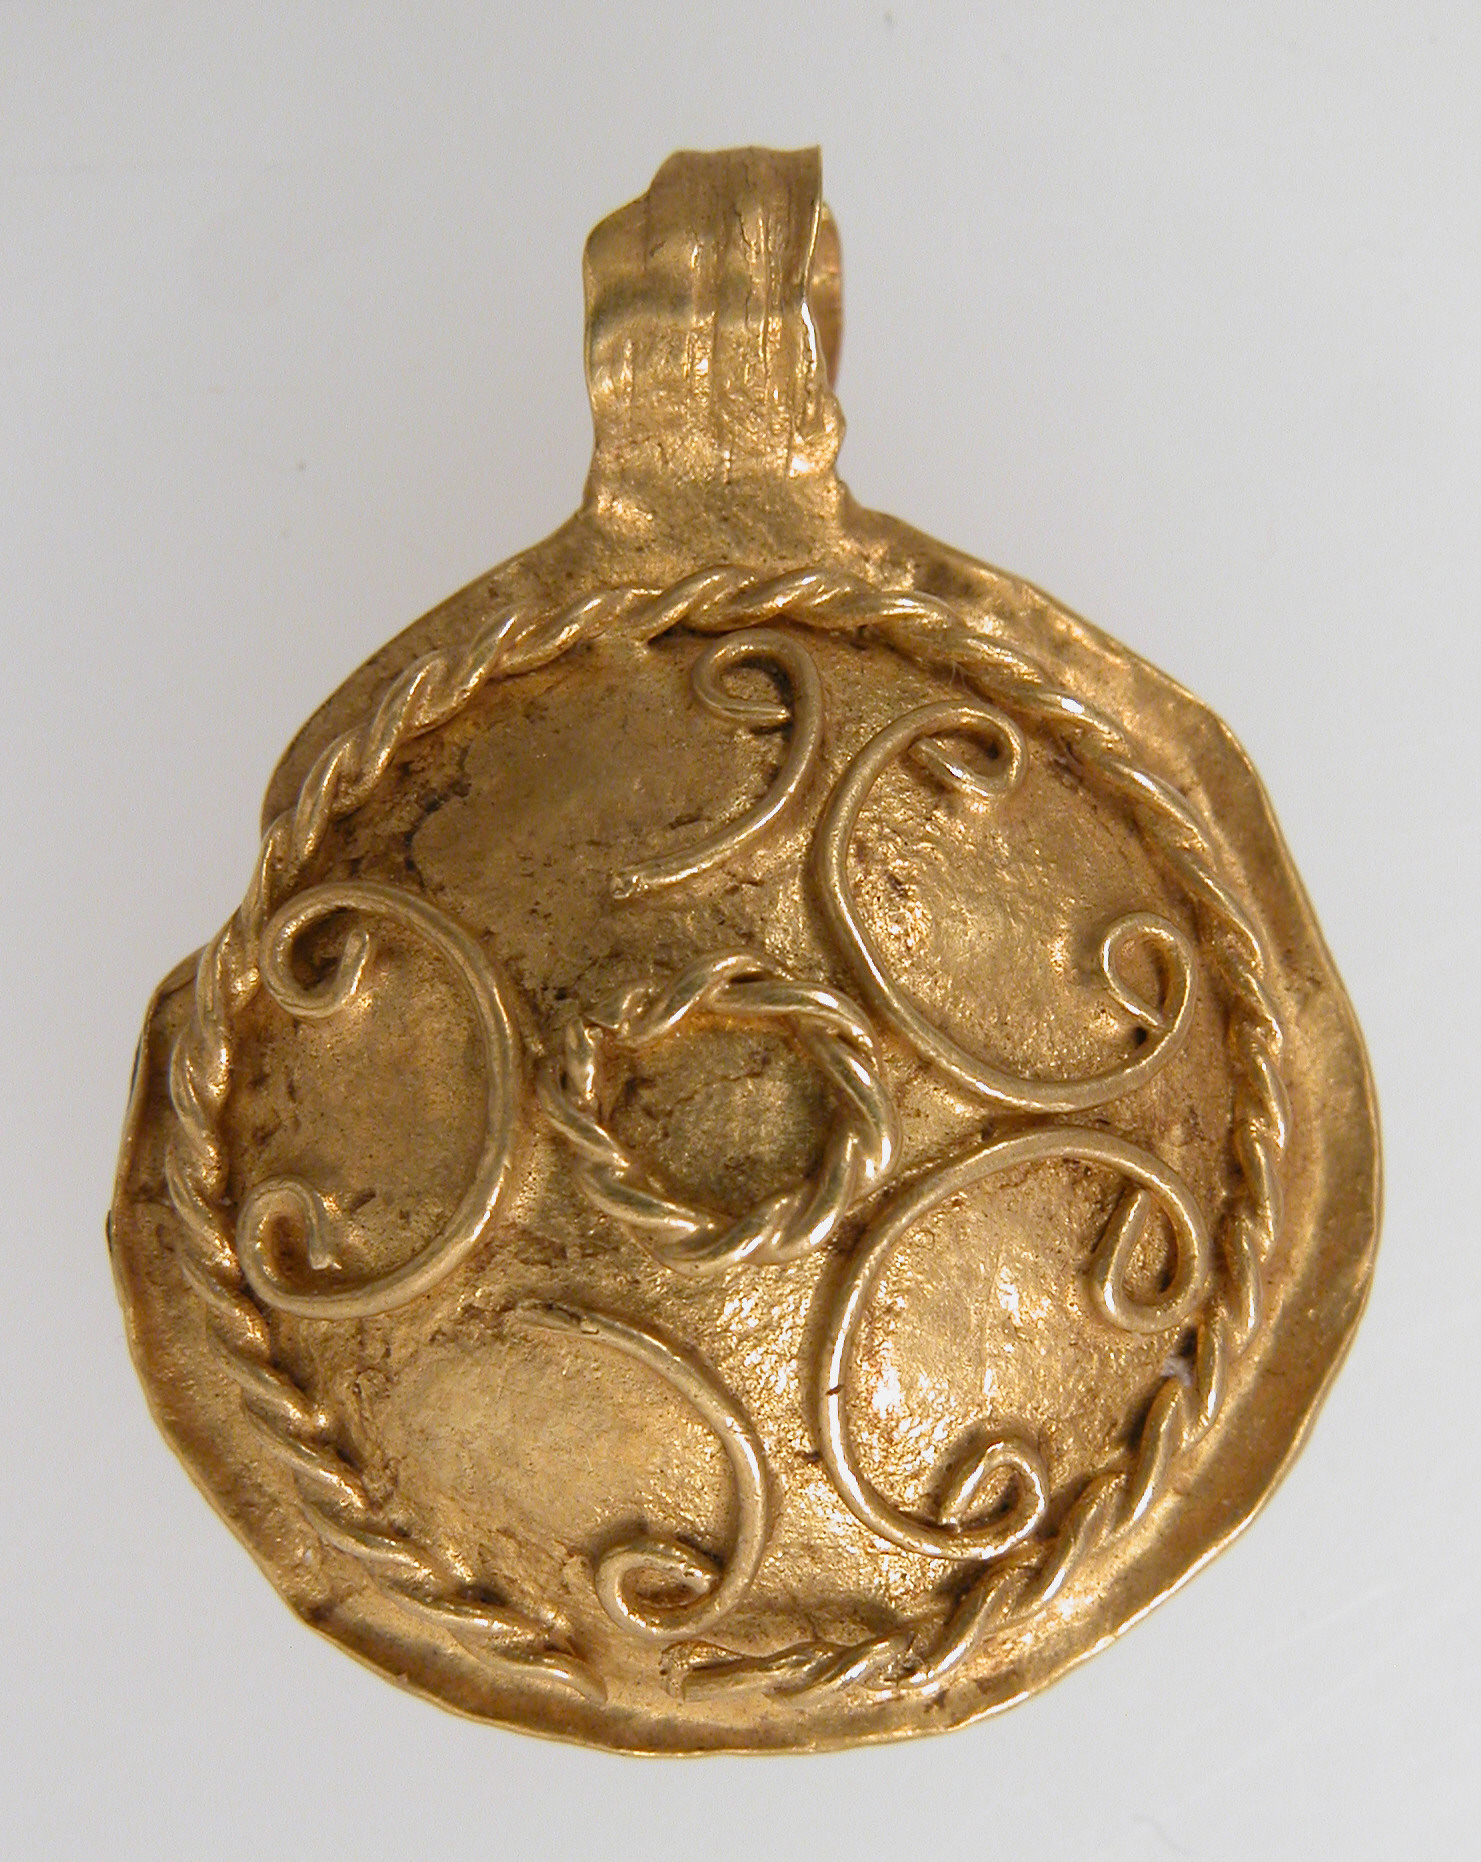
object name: pendant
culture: langobardic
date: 501-700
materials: gold